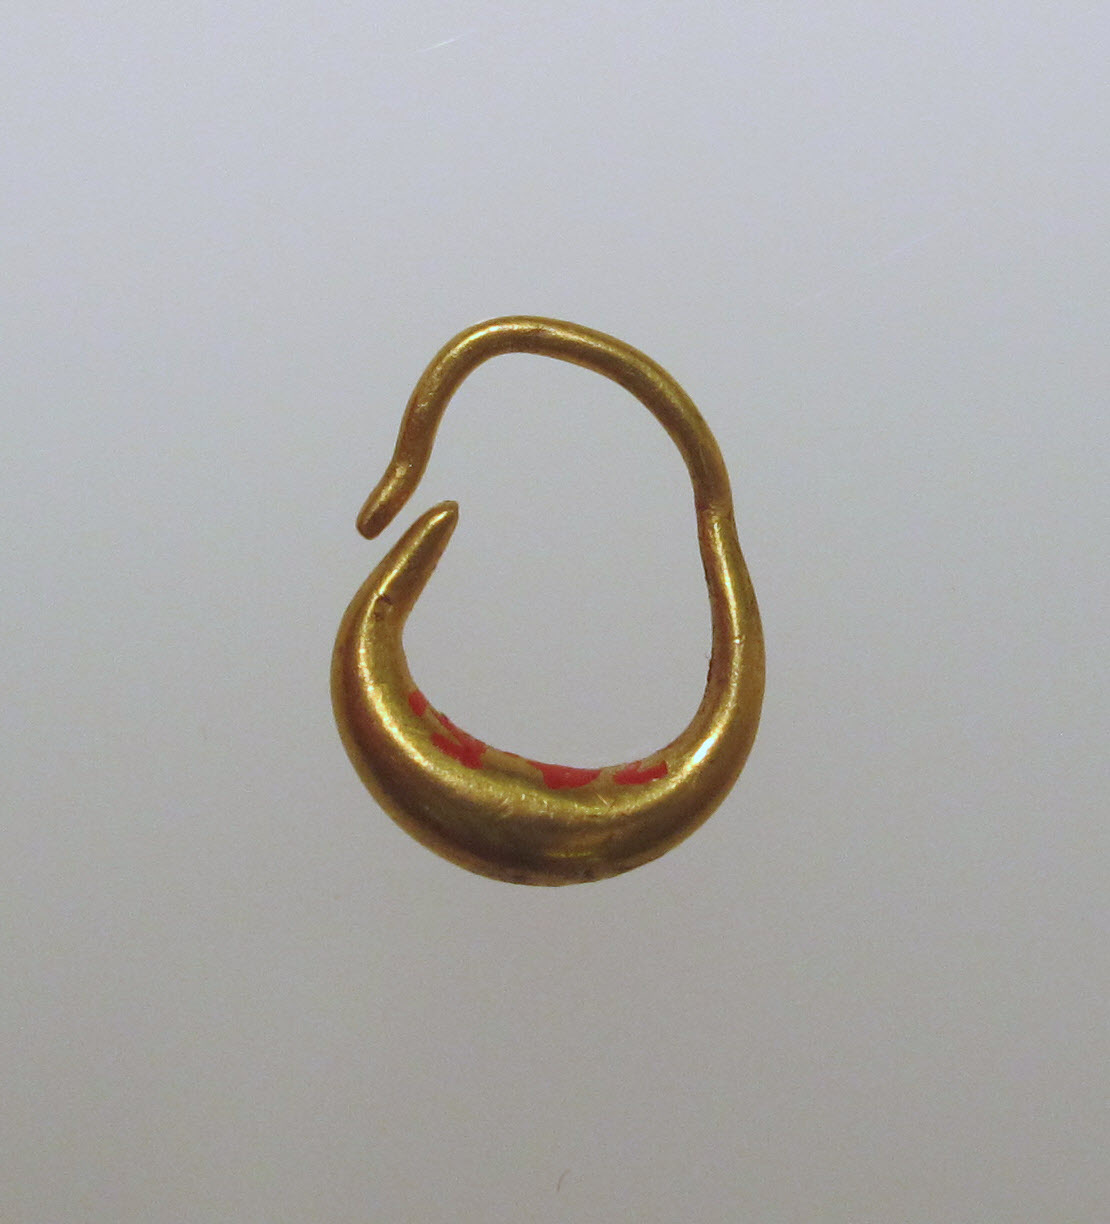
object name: earring, boat shaped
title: Earring, boat-shaped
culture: cypriot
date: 3900 BCE-100 CE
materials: gold